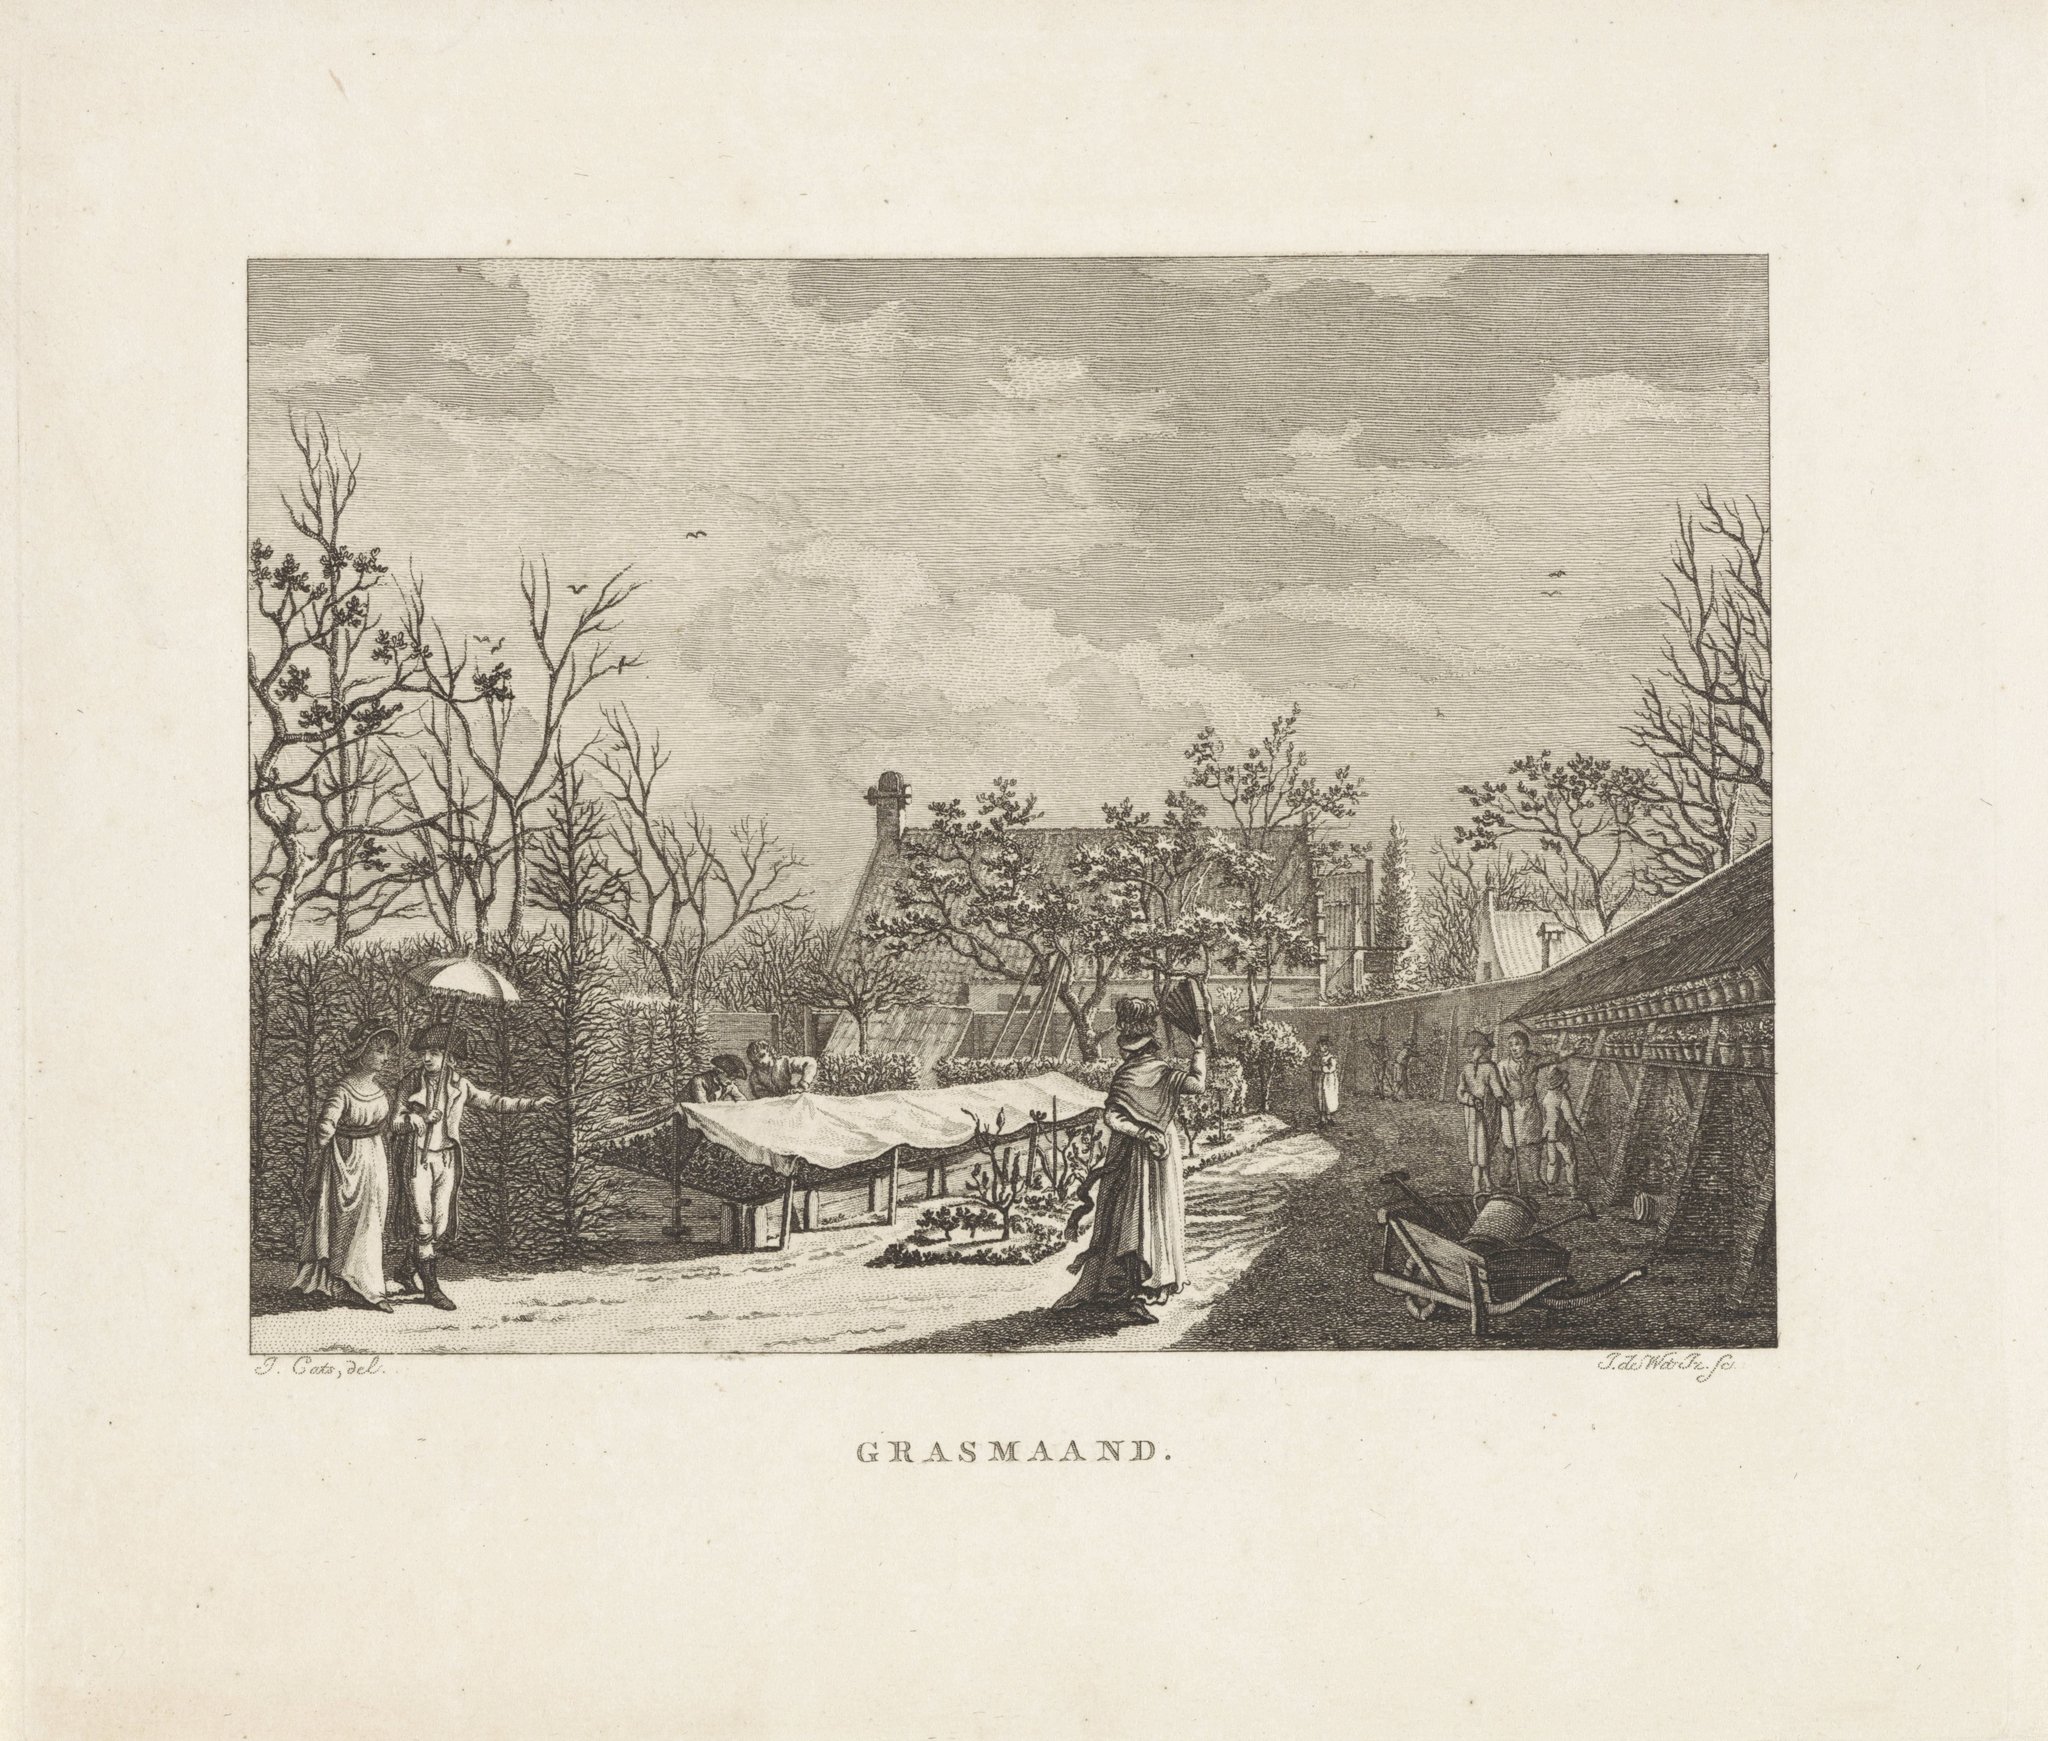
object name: print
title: Figuren in een ommuurde tuin met kweekbakken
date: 1807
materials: paper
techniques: etching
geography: haarlem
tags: forcing bed, april and its 'labours' (+ with scenes showing human occupations ~ seasons and months), gardening-tools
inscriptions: signature: ‘J. Cats del.’, collector's mark: Lugt 2228, signature: ‘I. de Wit Jz. fc’, title: ‘GRASMAAND’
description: Bezoekers in een tuin of kwekerij bekijken planten. Op de voorgrond een kruiwagen met daarin een gieter en een schop.